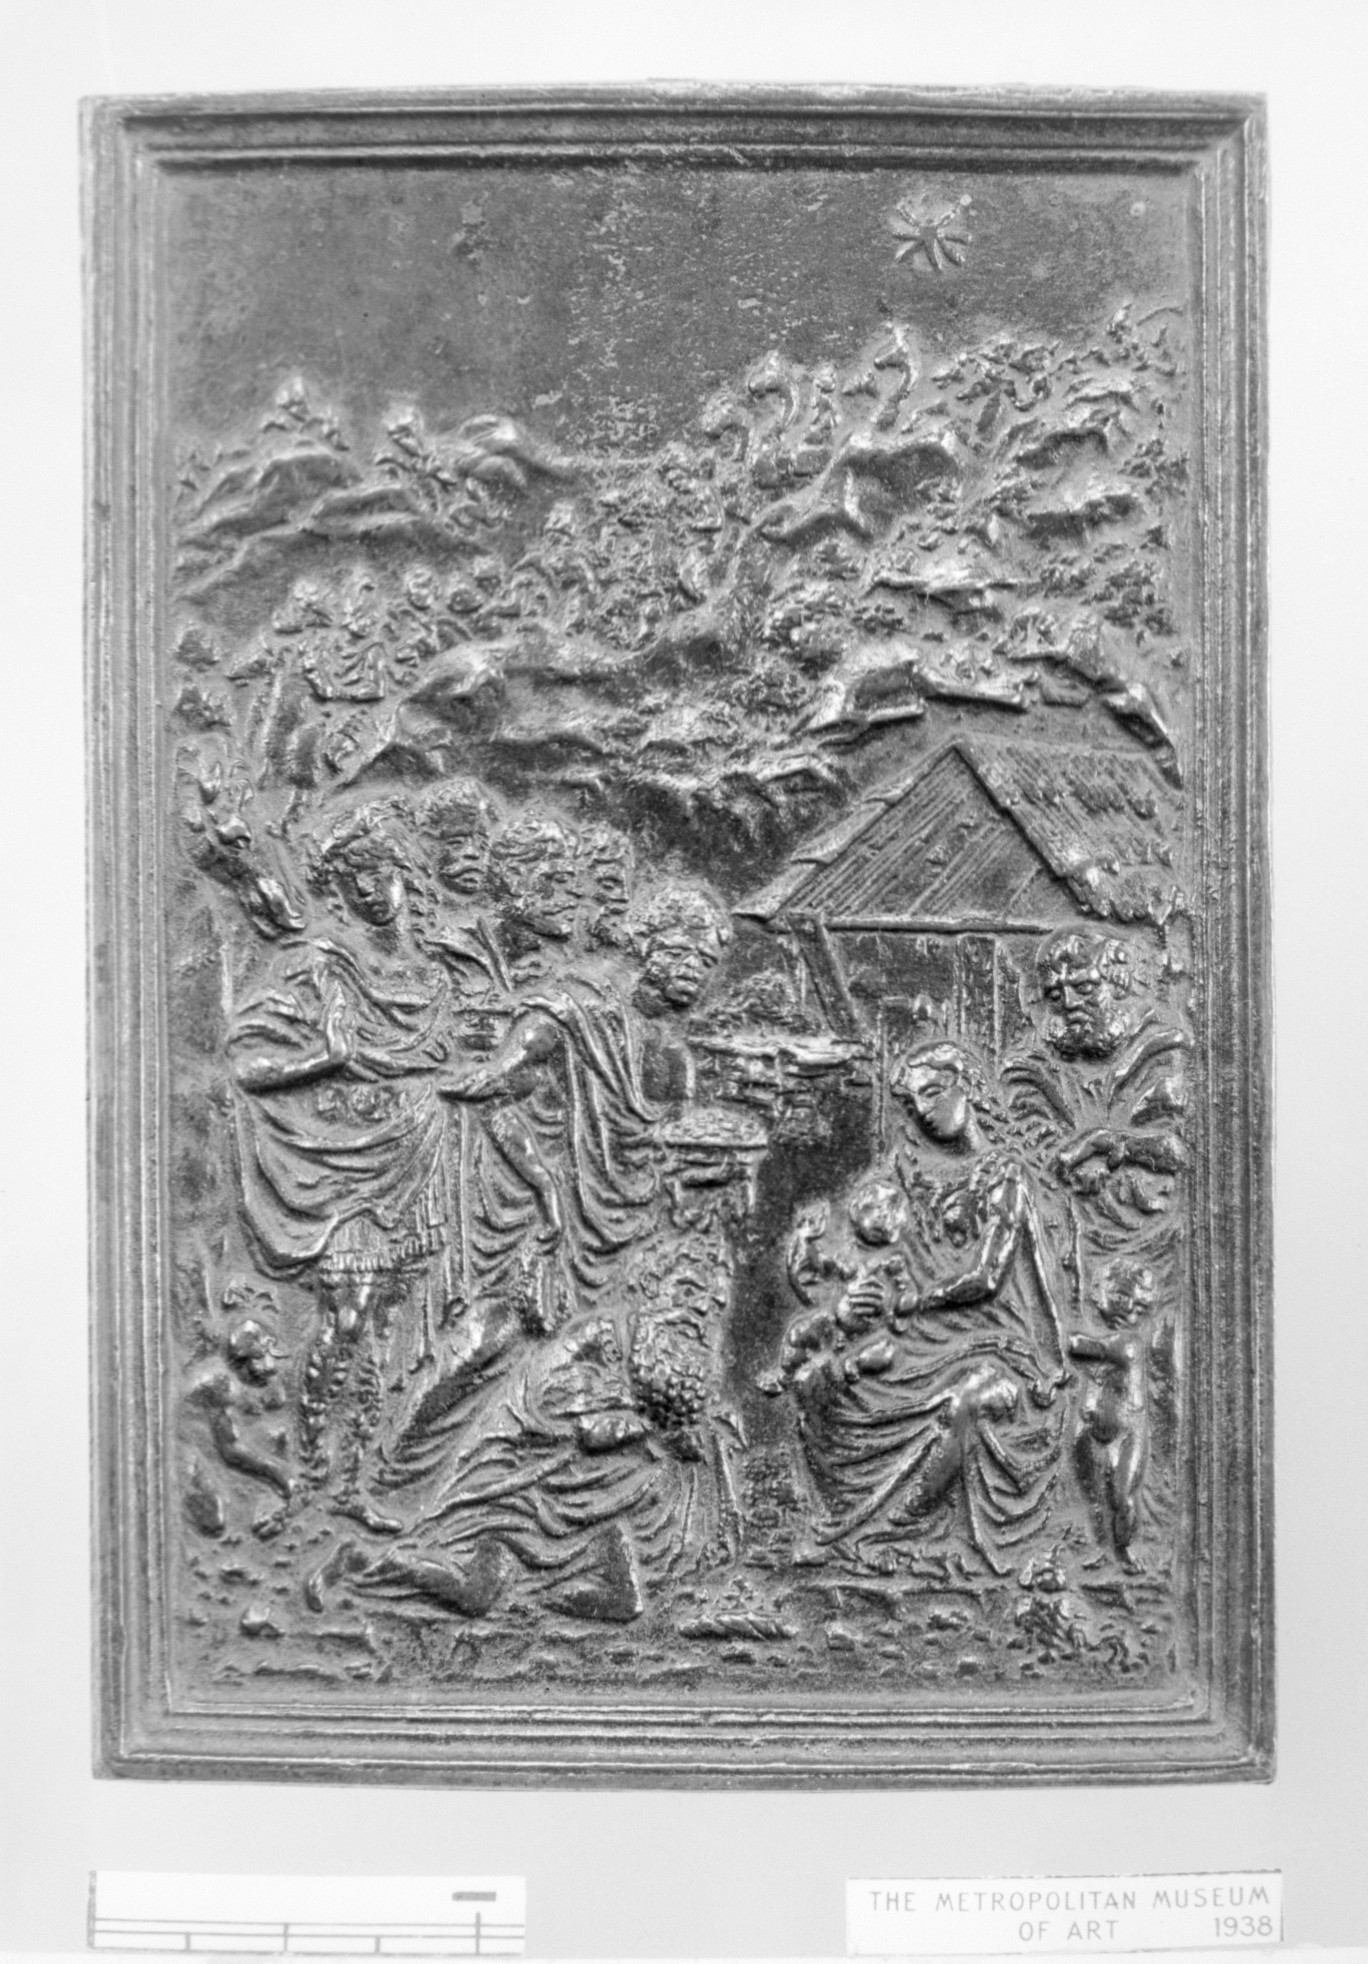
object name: plaquette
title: Adoration of the Magi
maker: moderno (galeazzo mondella)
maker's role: artist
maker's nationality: italian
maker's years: 1467-1528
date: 1467-1533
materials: bronze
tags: jesus,adoration of the magi